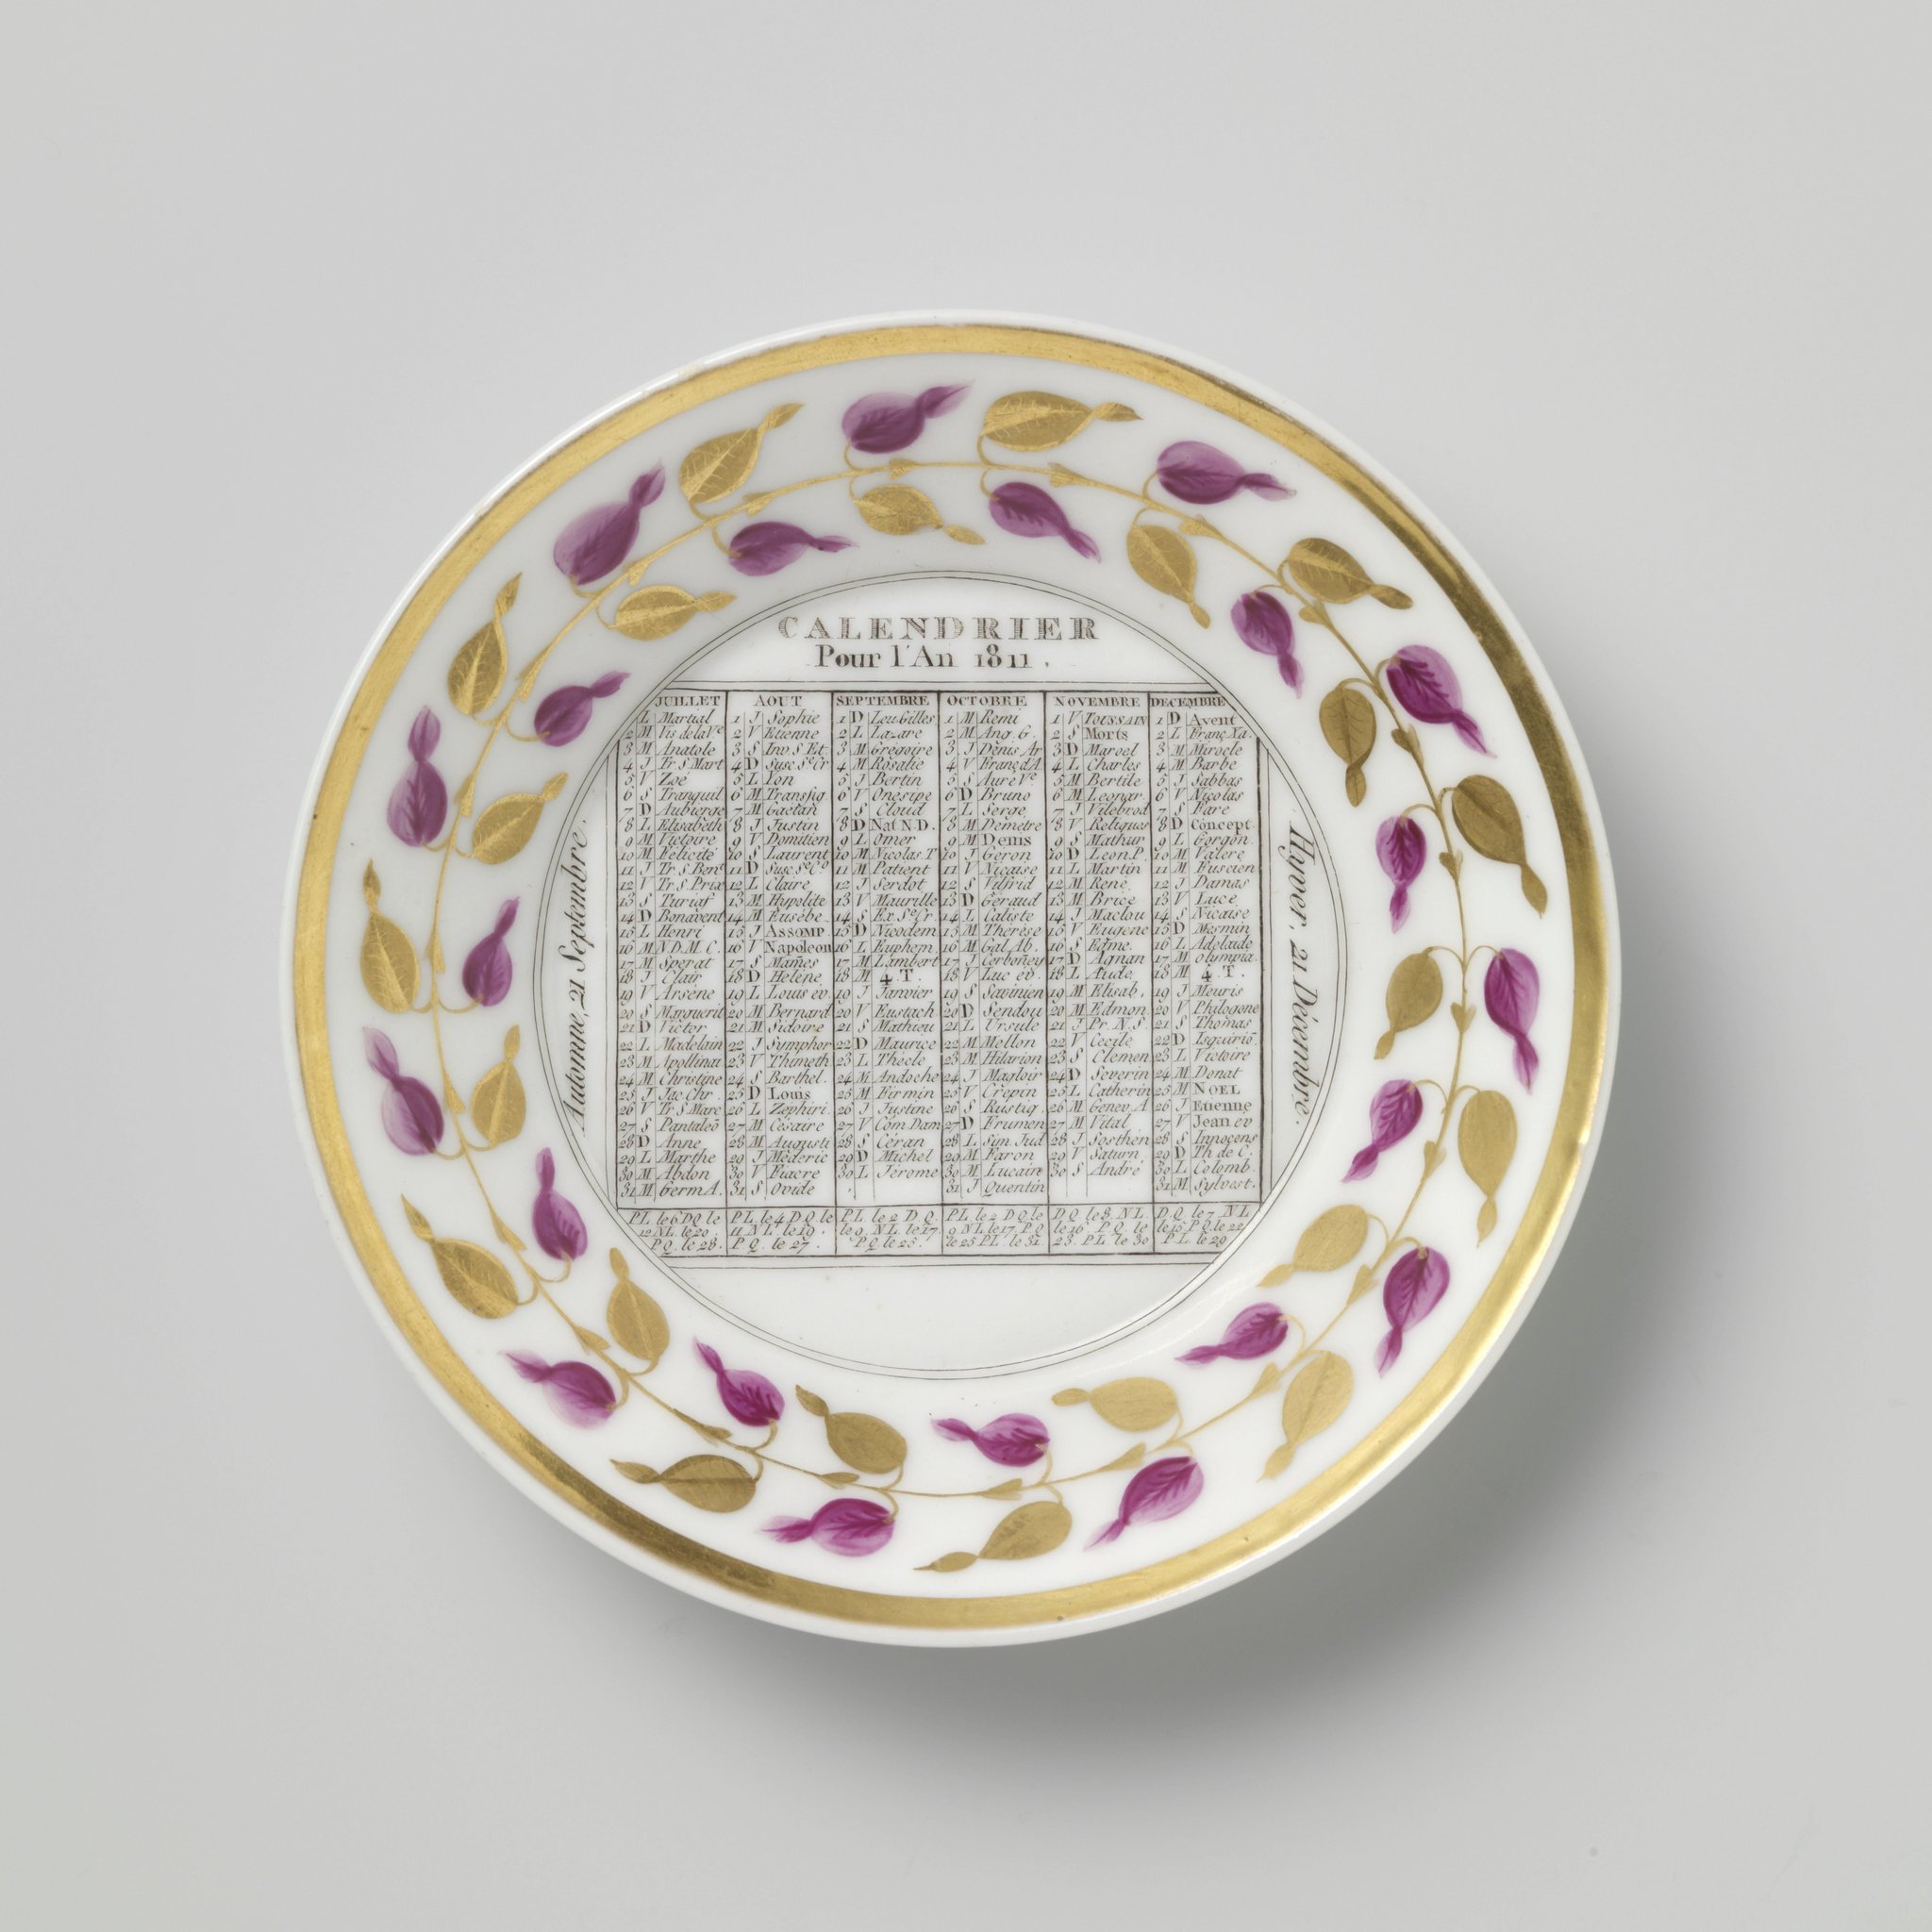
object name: cup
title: Cup with a foliate scroll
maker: Anonymous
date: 1811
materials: glaze, gold, paint, porcelain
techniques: firing, forming, gilding, turning, vitrification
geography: paris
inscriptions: mark: ‘K’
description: Kop van porselein met een cilindrische wand en C-vormig oor, beschilderd op het glazuur in paars en goud. Op de buitenwand een doorlopende bladrank met om en om gouden en paarse bladeren. Boven de voet en op de rand een gouden band. Gouden lijn op het oor. Gemerkt op de onderzijde met K.